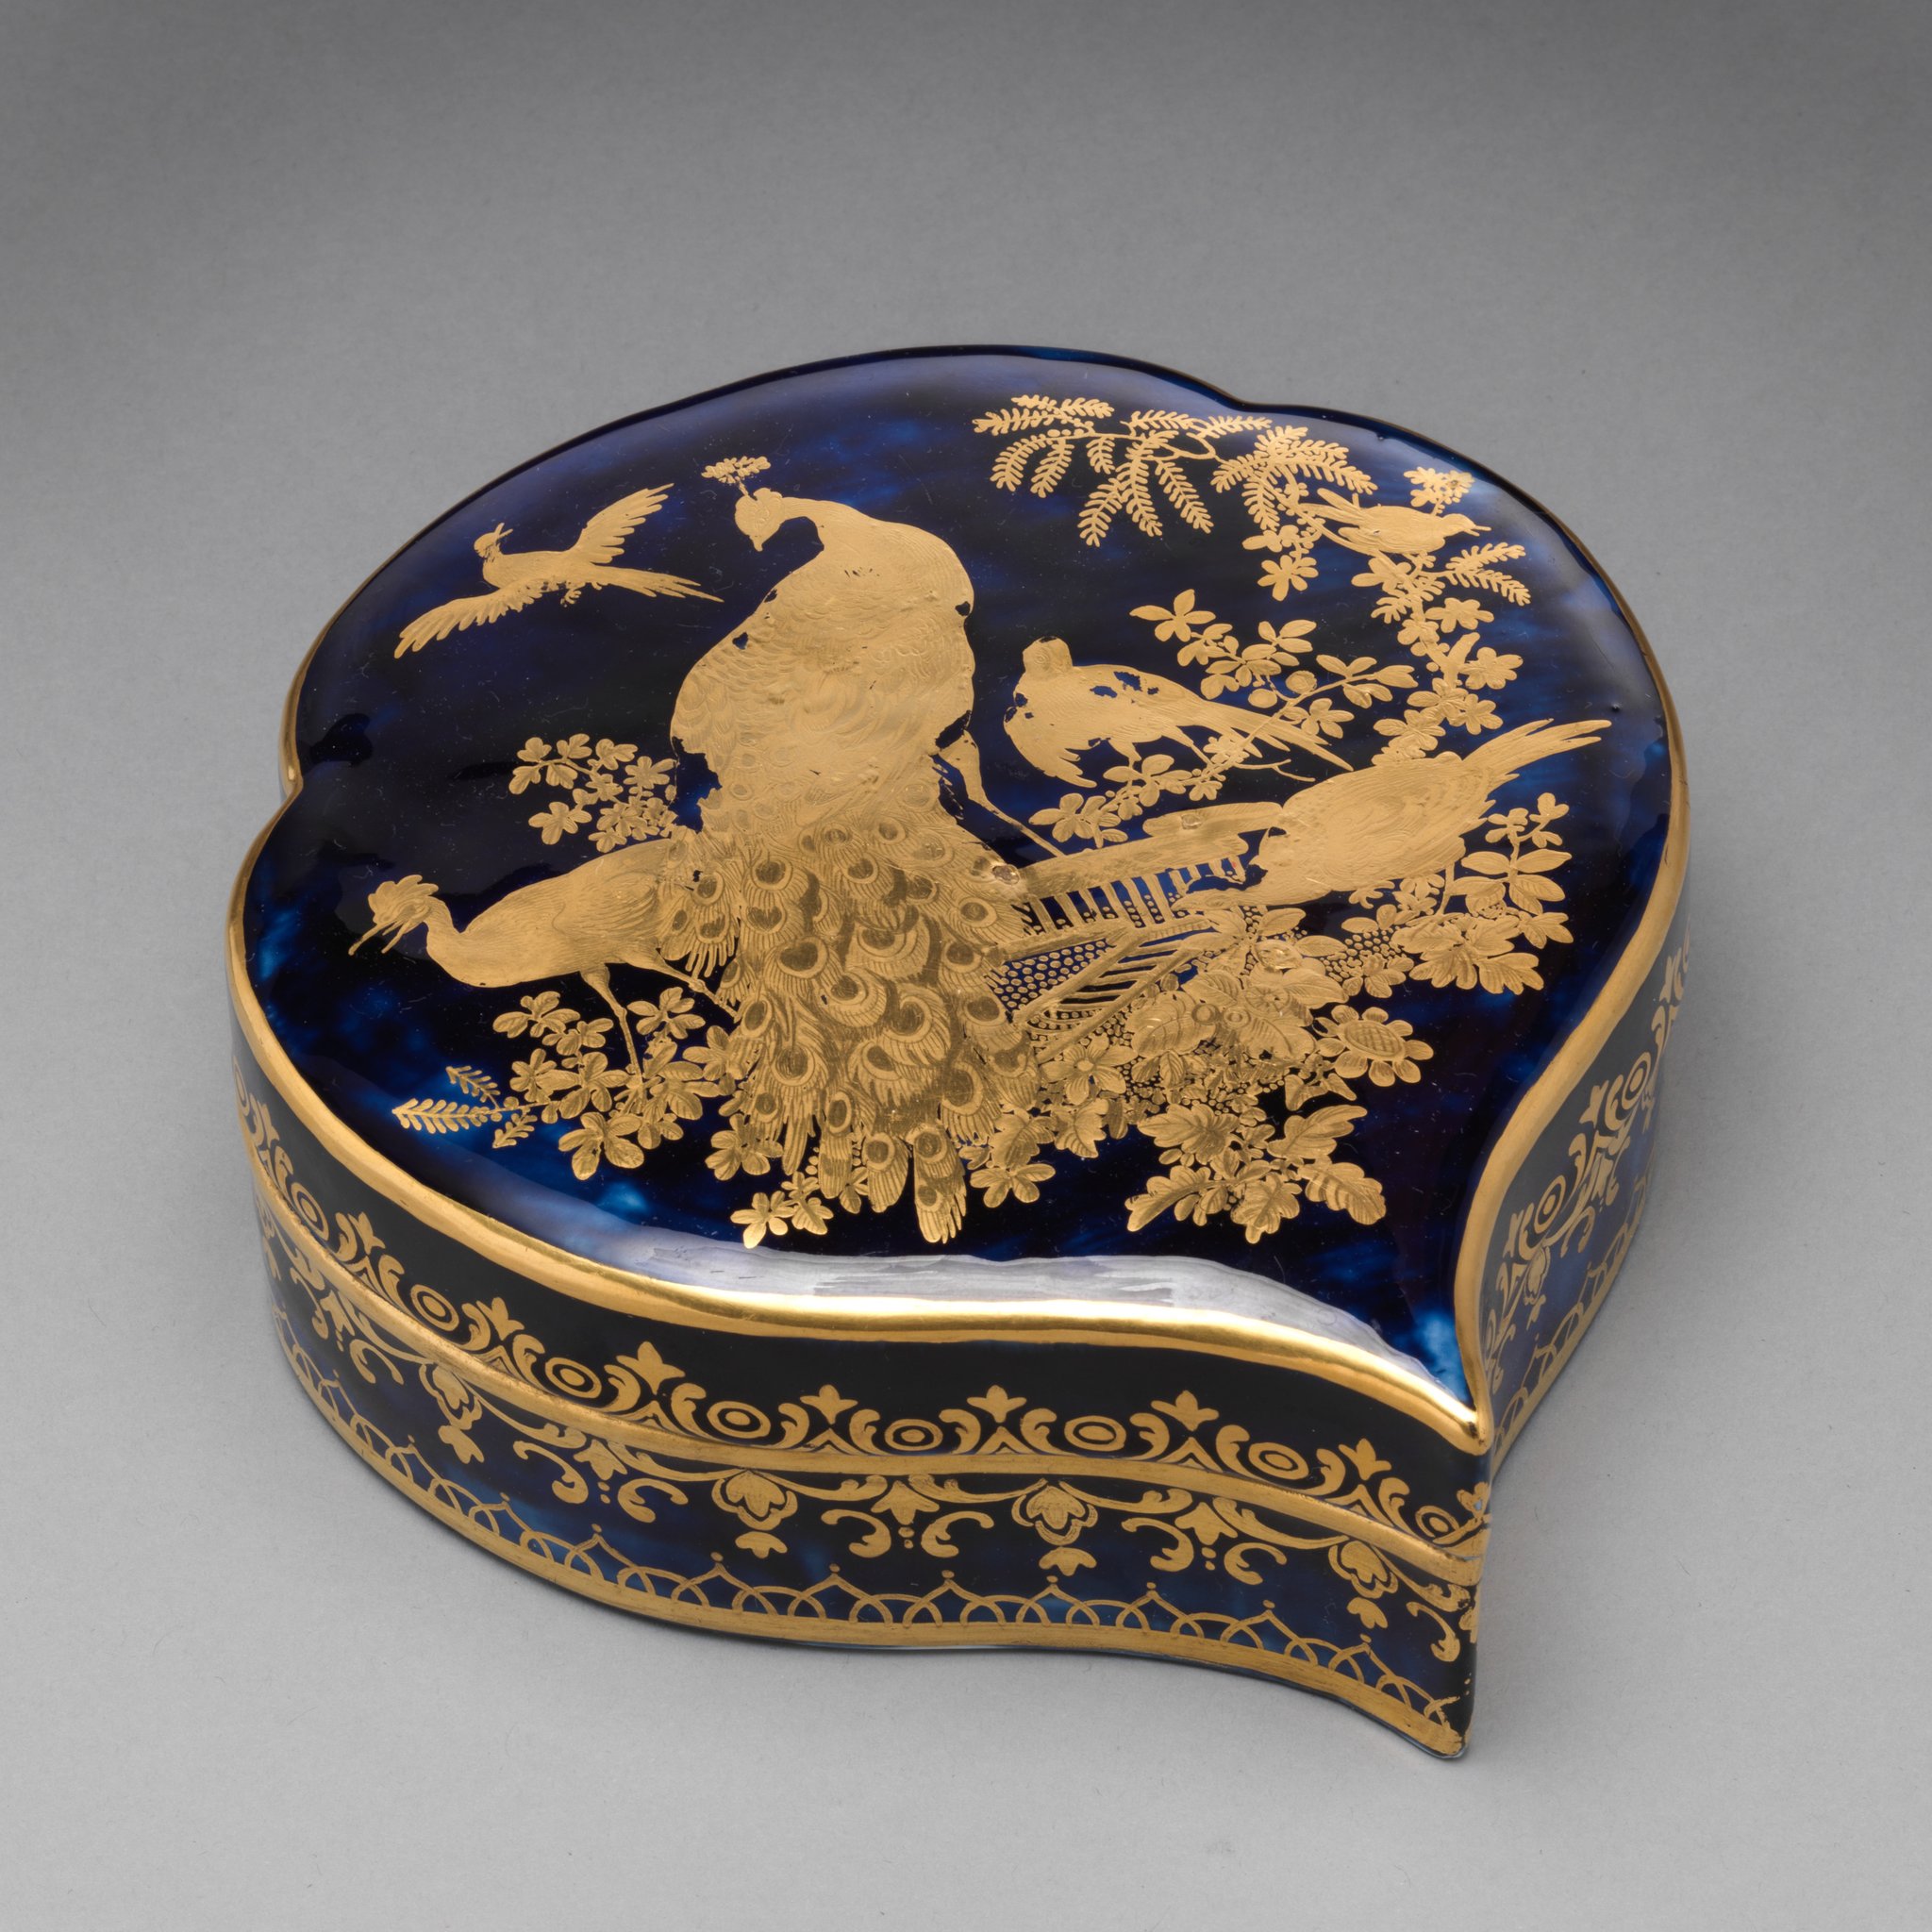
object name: toilet box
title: Toilet box containing four smaller boxes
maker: chelsea porcelain manufactory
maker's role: factory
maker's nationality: british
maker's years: 1744-1784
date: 1761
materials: gold, soft paste porcelain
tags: peacocks,flowers